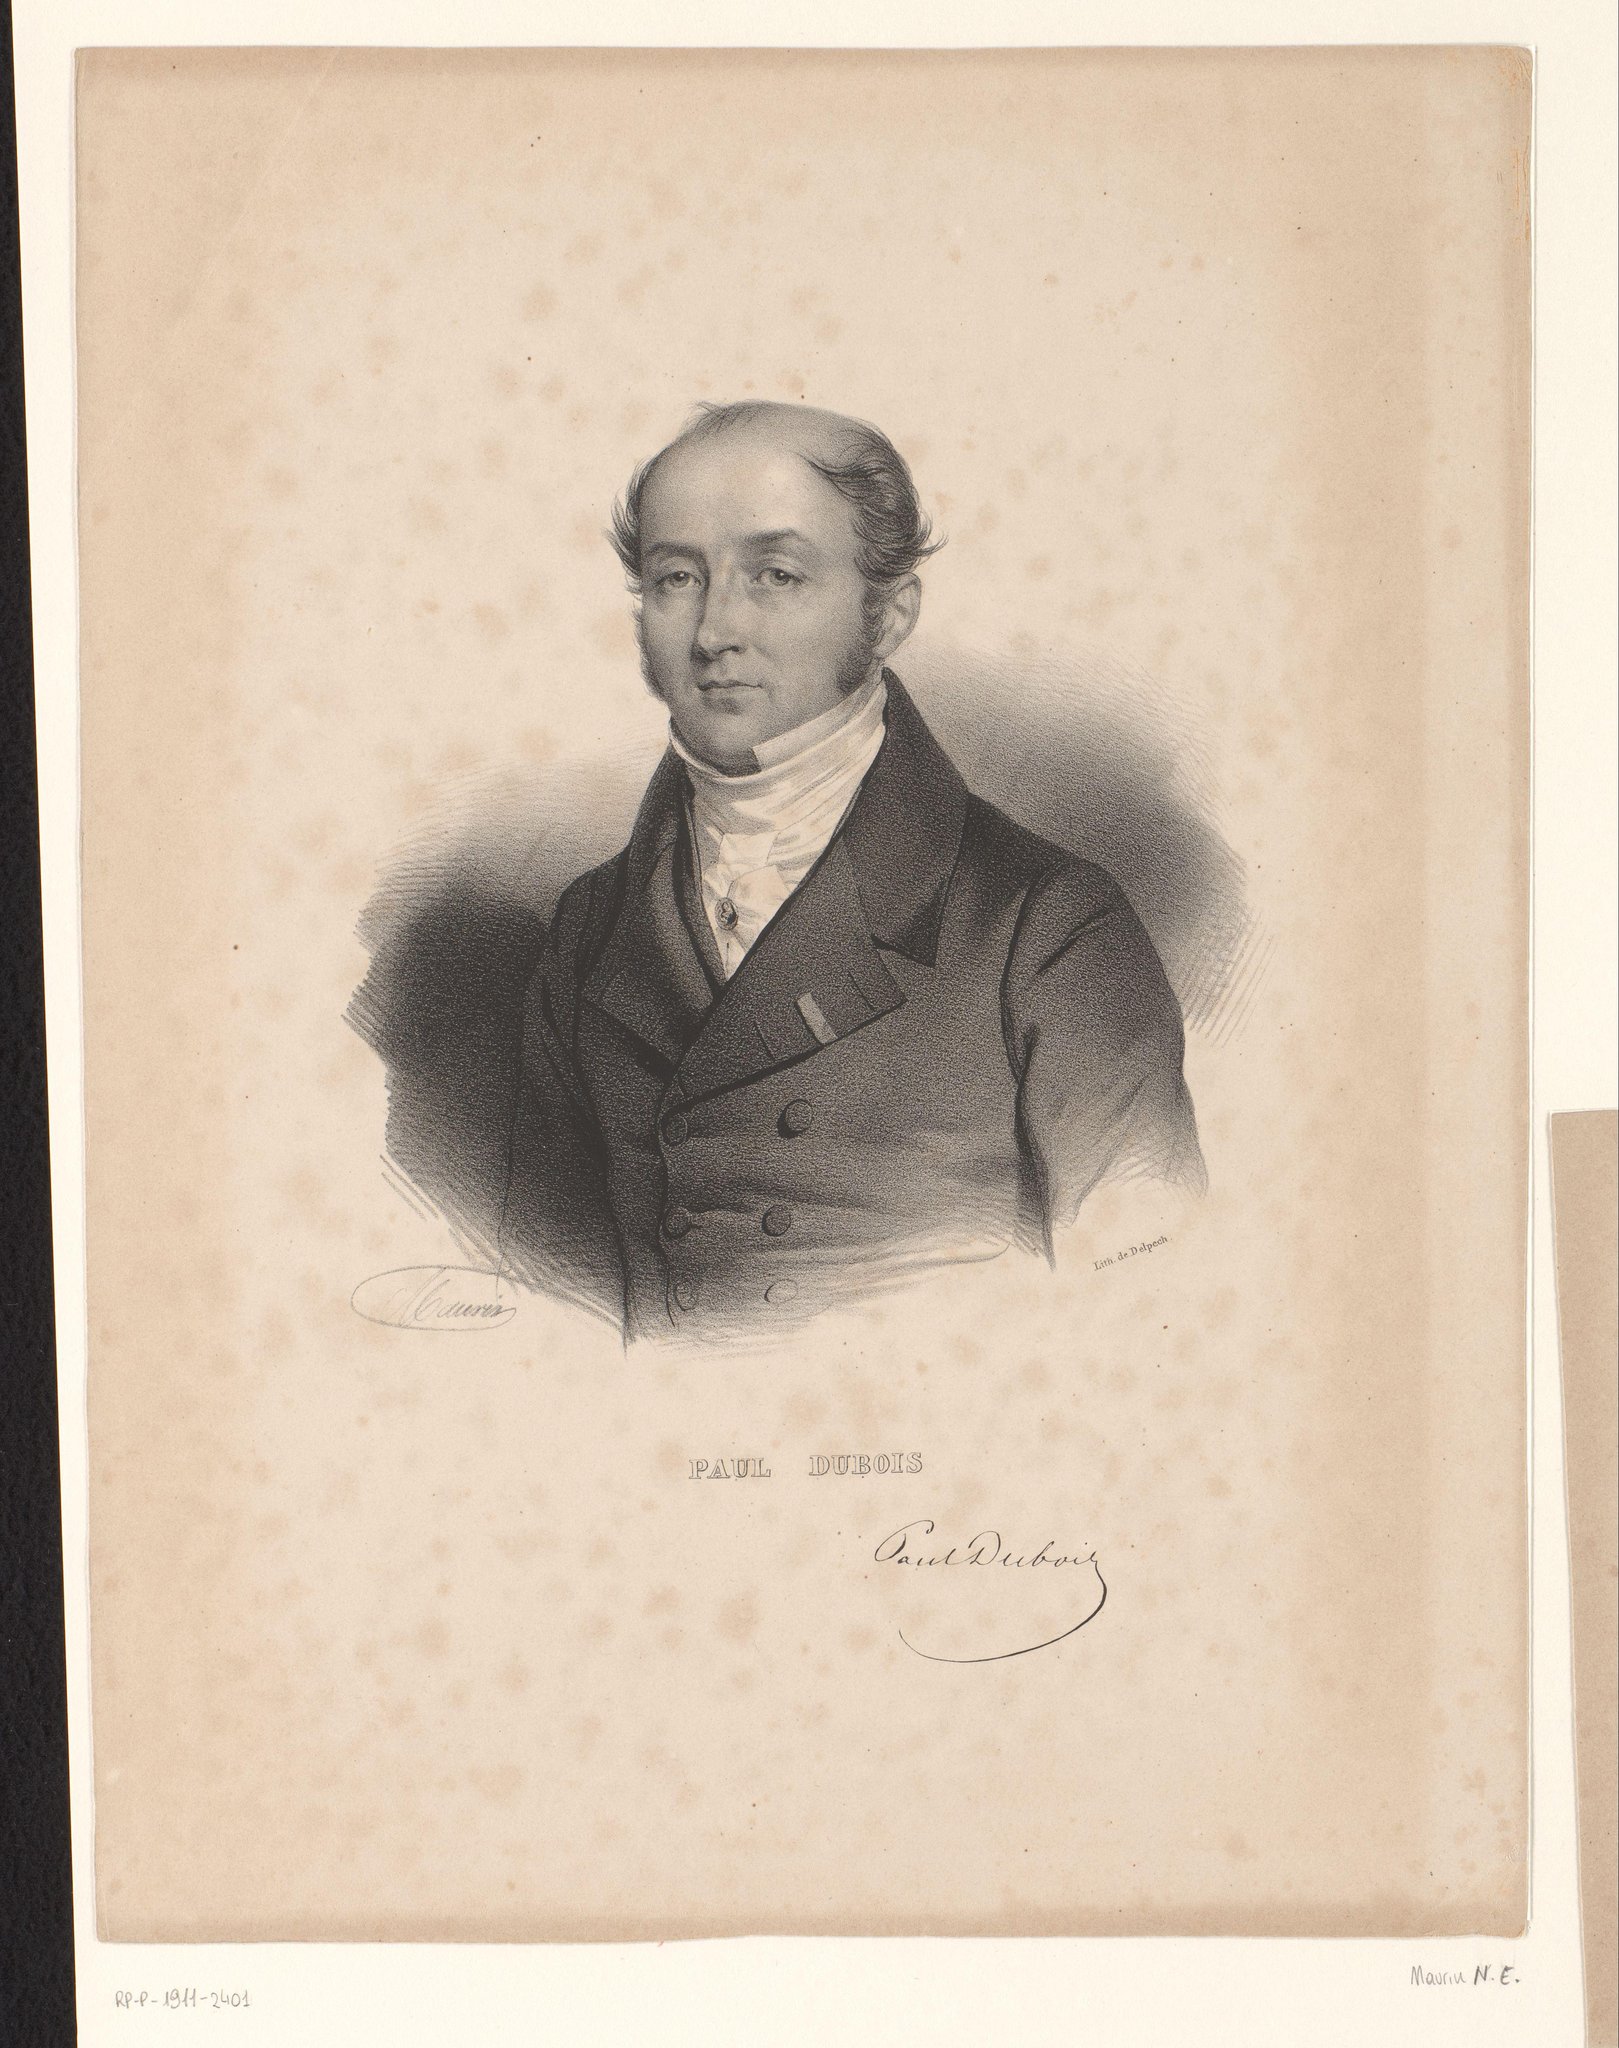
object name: print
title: Portret van arts Paul Antoine Dubois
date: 1838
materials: paper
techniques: lithograph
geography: paris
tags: paris, historical persons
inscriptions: collector's mark: Lugt 2228